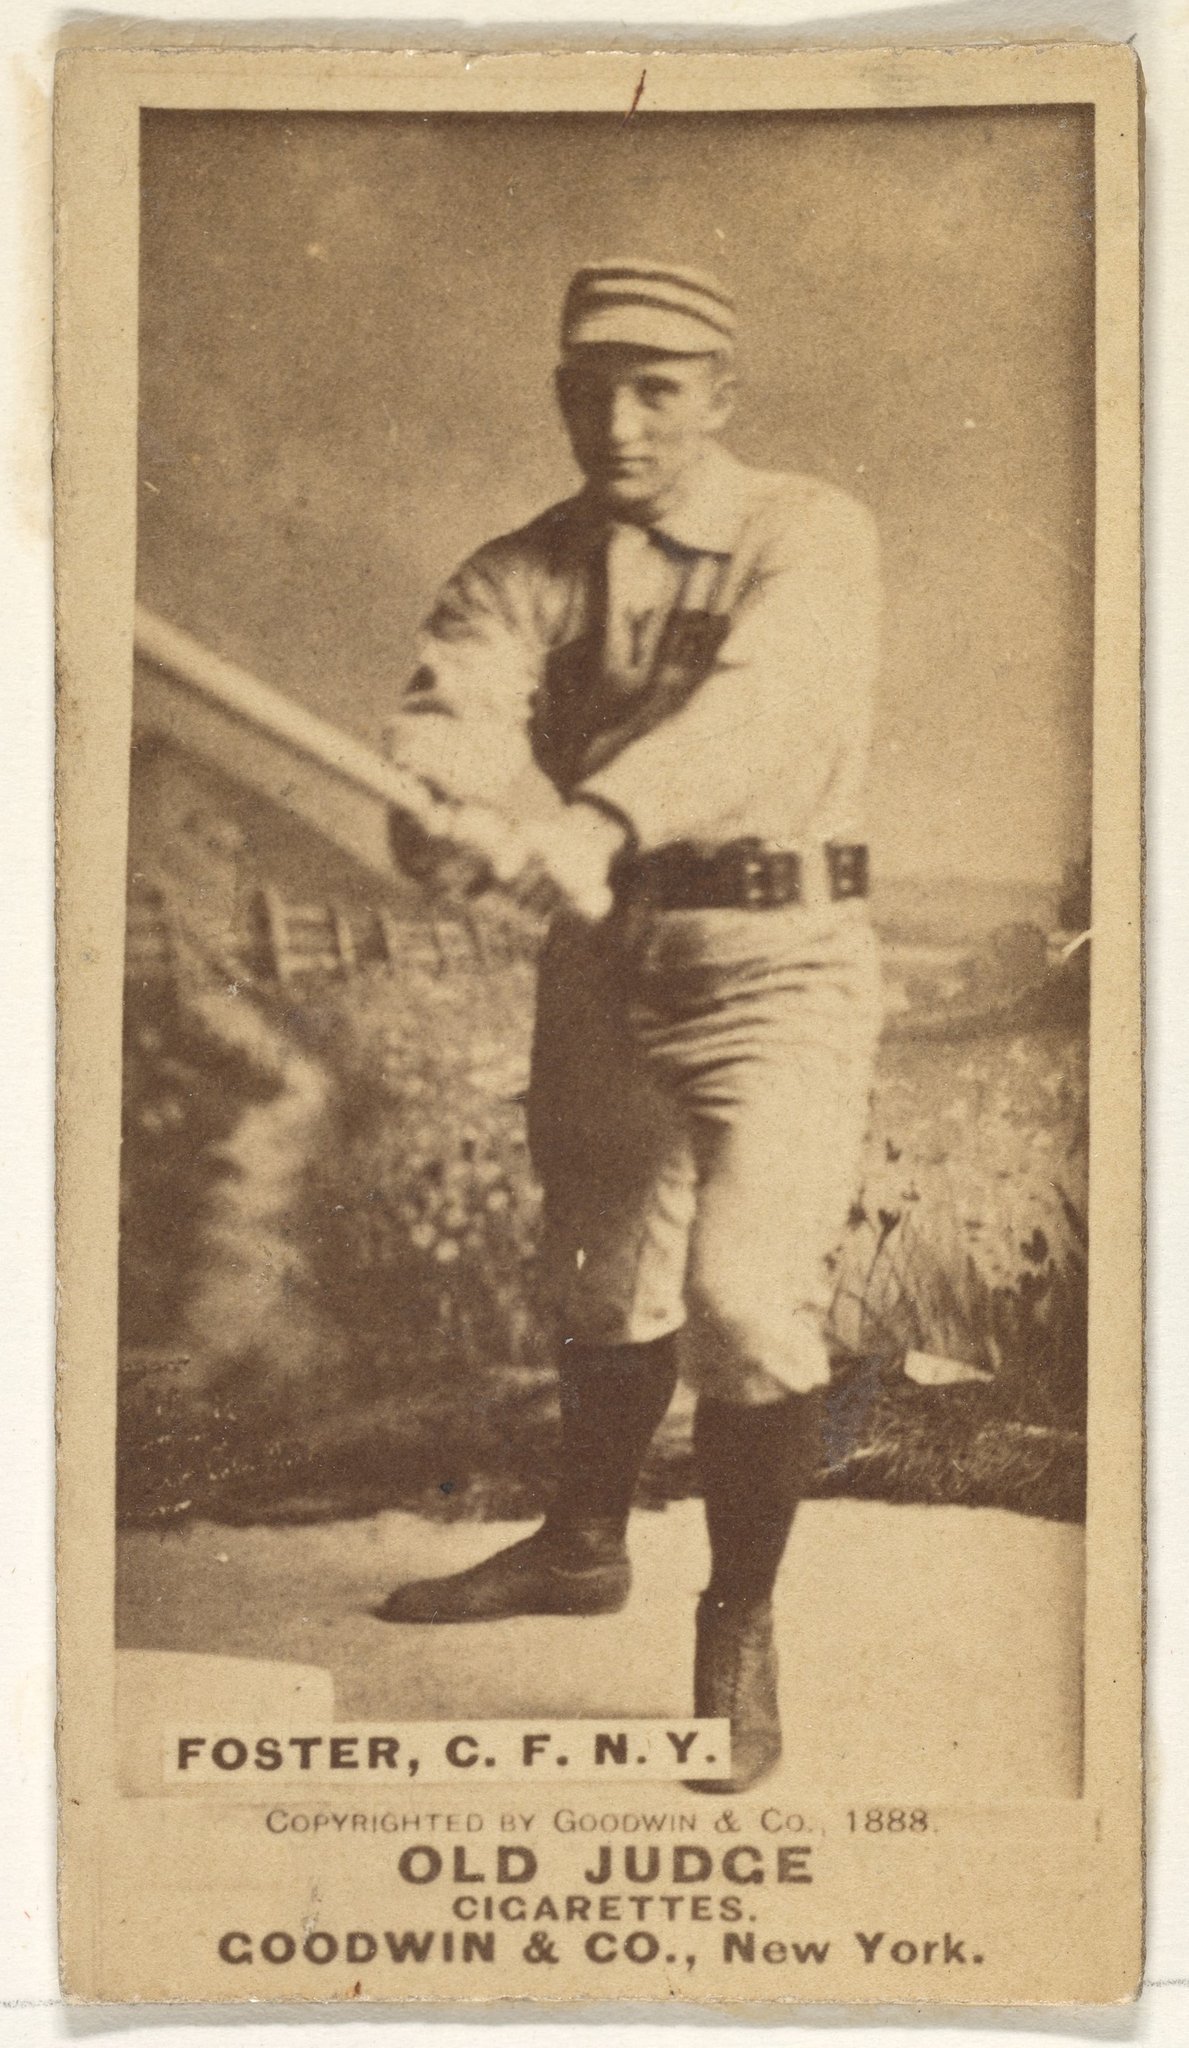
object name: baseball card, photograph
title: Elmer Ellsworth Foster, Center Field, New York, from the Old Judge series (N172) for Old Judge Cigarettes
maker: goodwin & company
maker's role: publisher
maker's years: 1850-1950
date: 1888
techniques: albumen silver print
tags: men,portraits,baseball,athletes